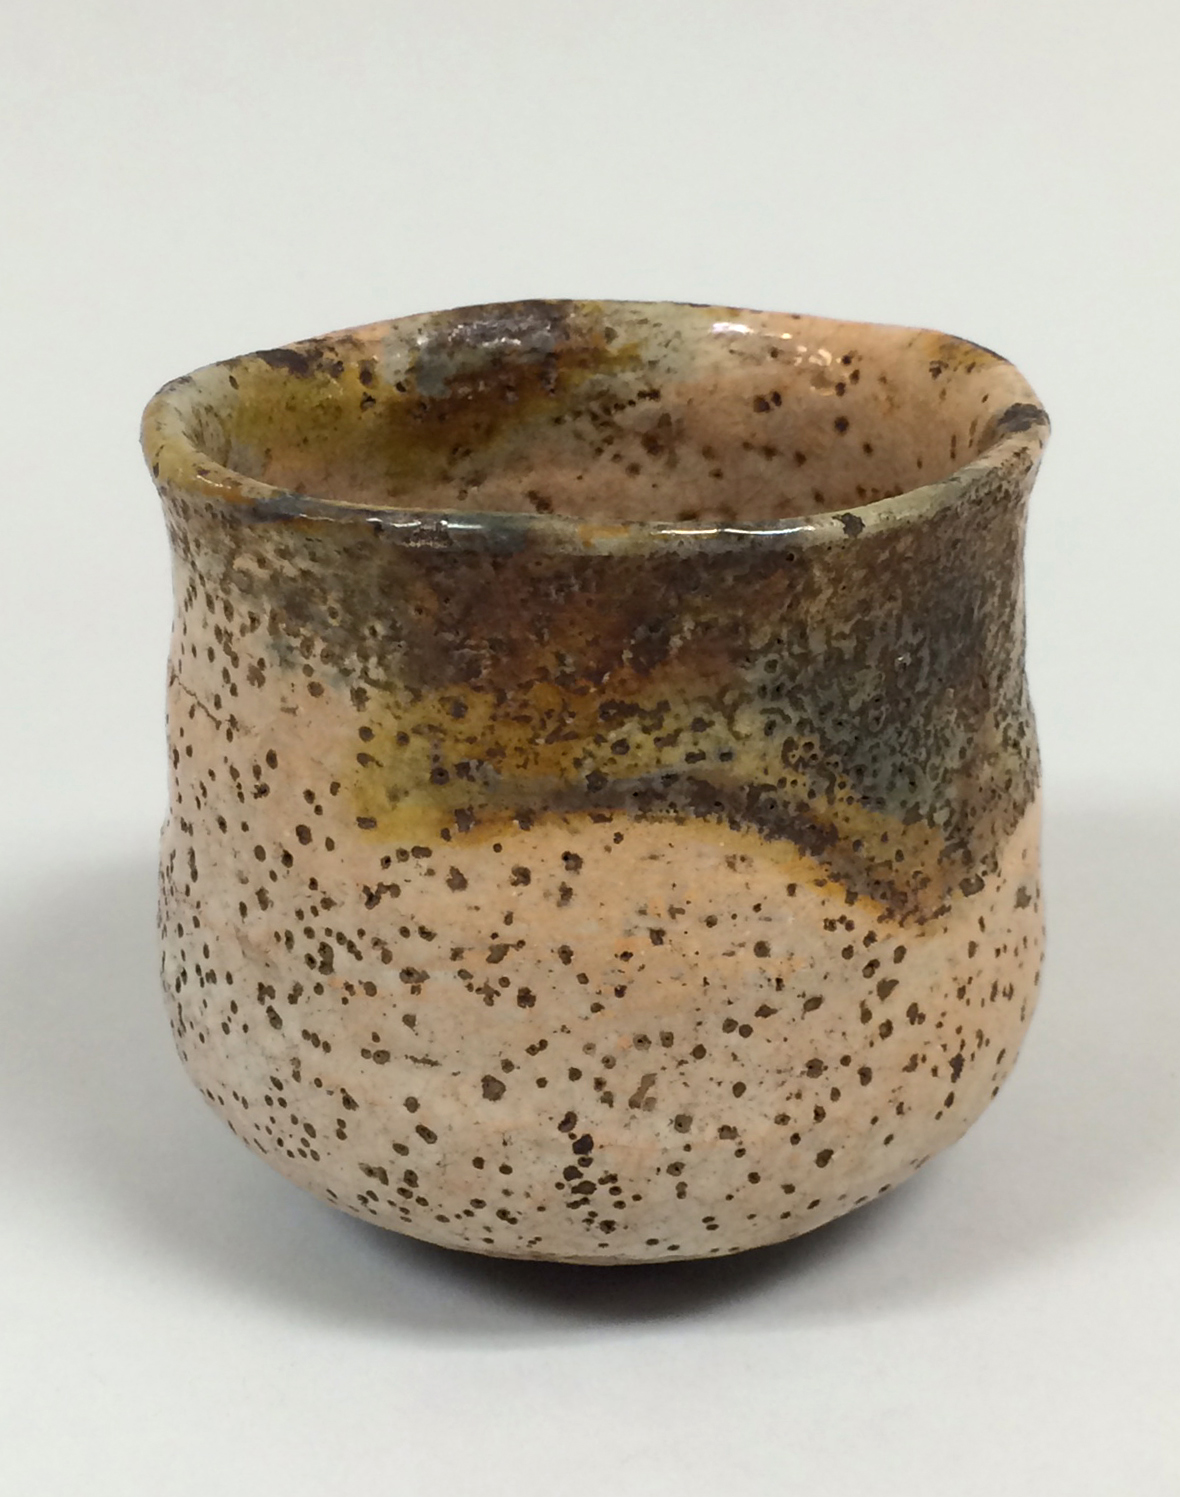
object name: teabowl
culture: japanese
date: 1780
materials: clay, glaze